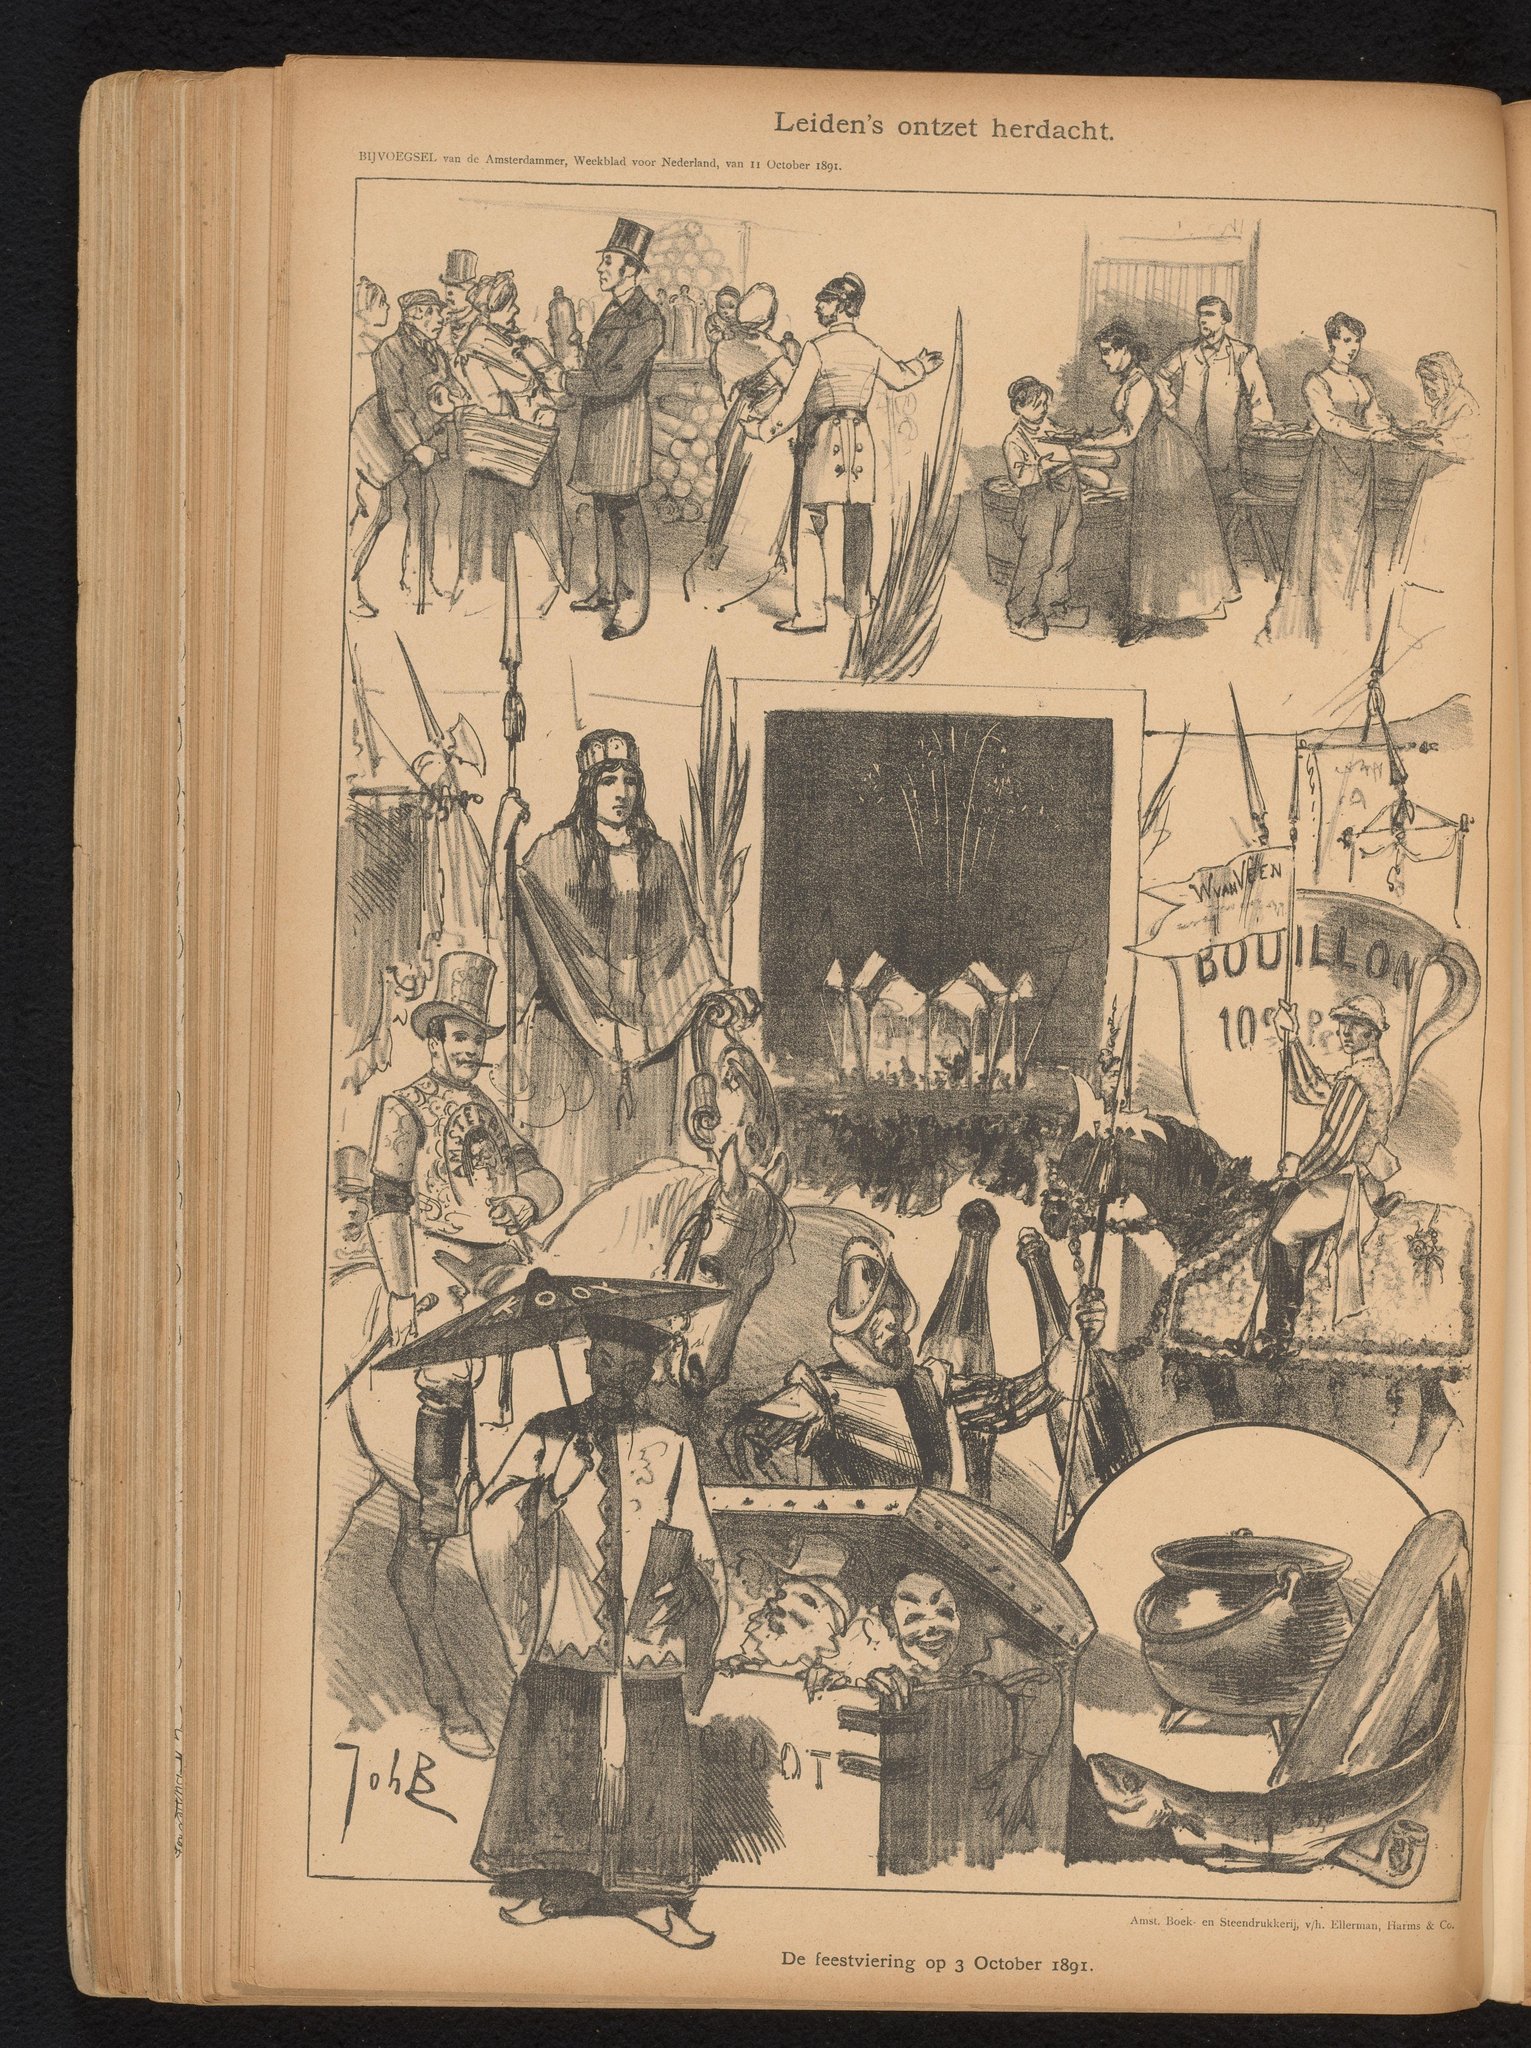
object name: print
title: Leiden's ontzet herdacht / De feestviering op 3 October 1891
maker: johan braakensiek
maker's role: draughtsman, print maker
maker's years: 1858-1940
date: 1891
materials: paper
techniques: lithograph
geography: amsterdam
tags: children's games and plays, royal household; courtiers, retinue, train, political caricatures and satires, leiden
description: Verschillende scènes van de viering van het Leids ontzet op 3 oktober 1891.